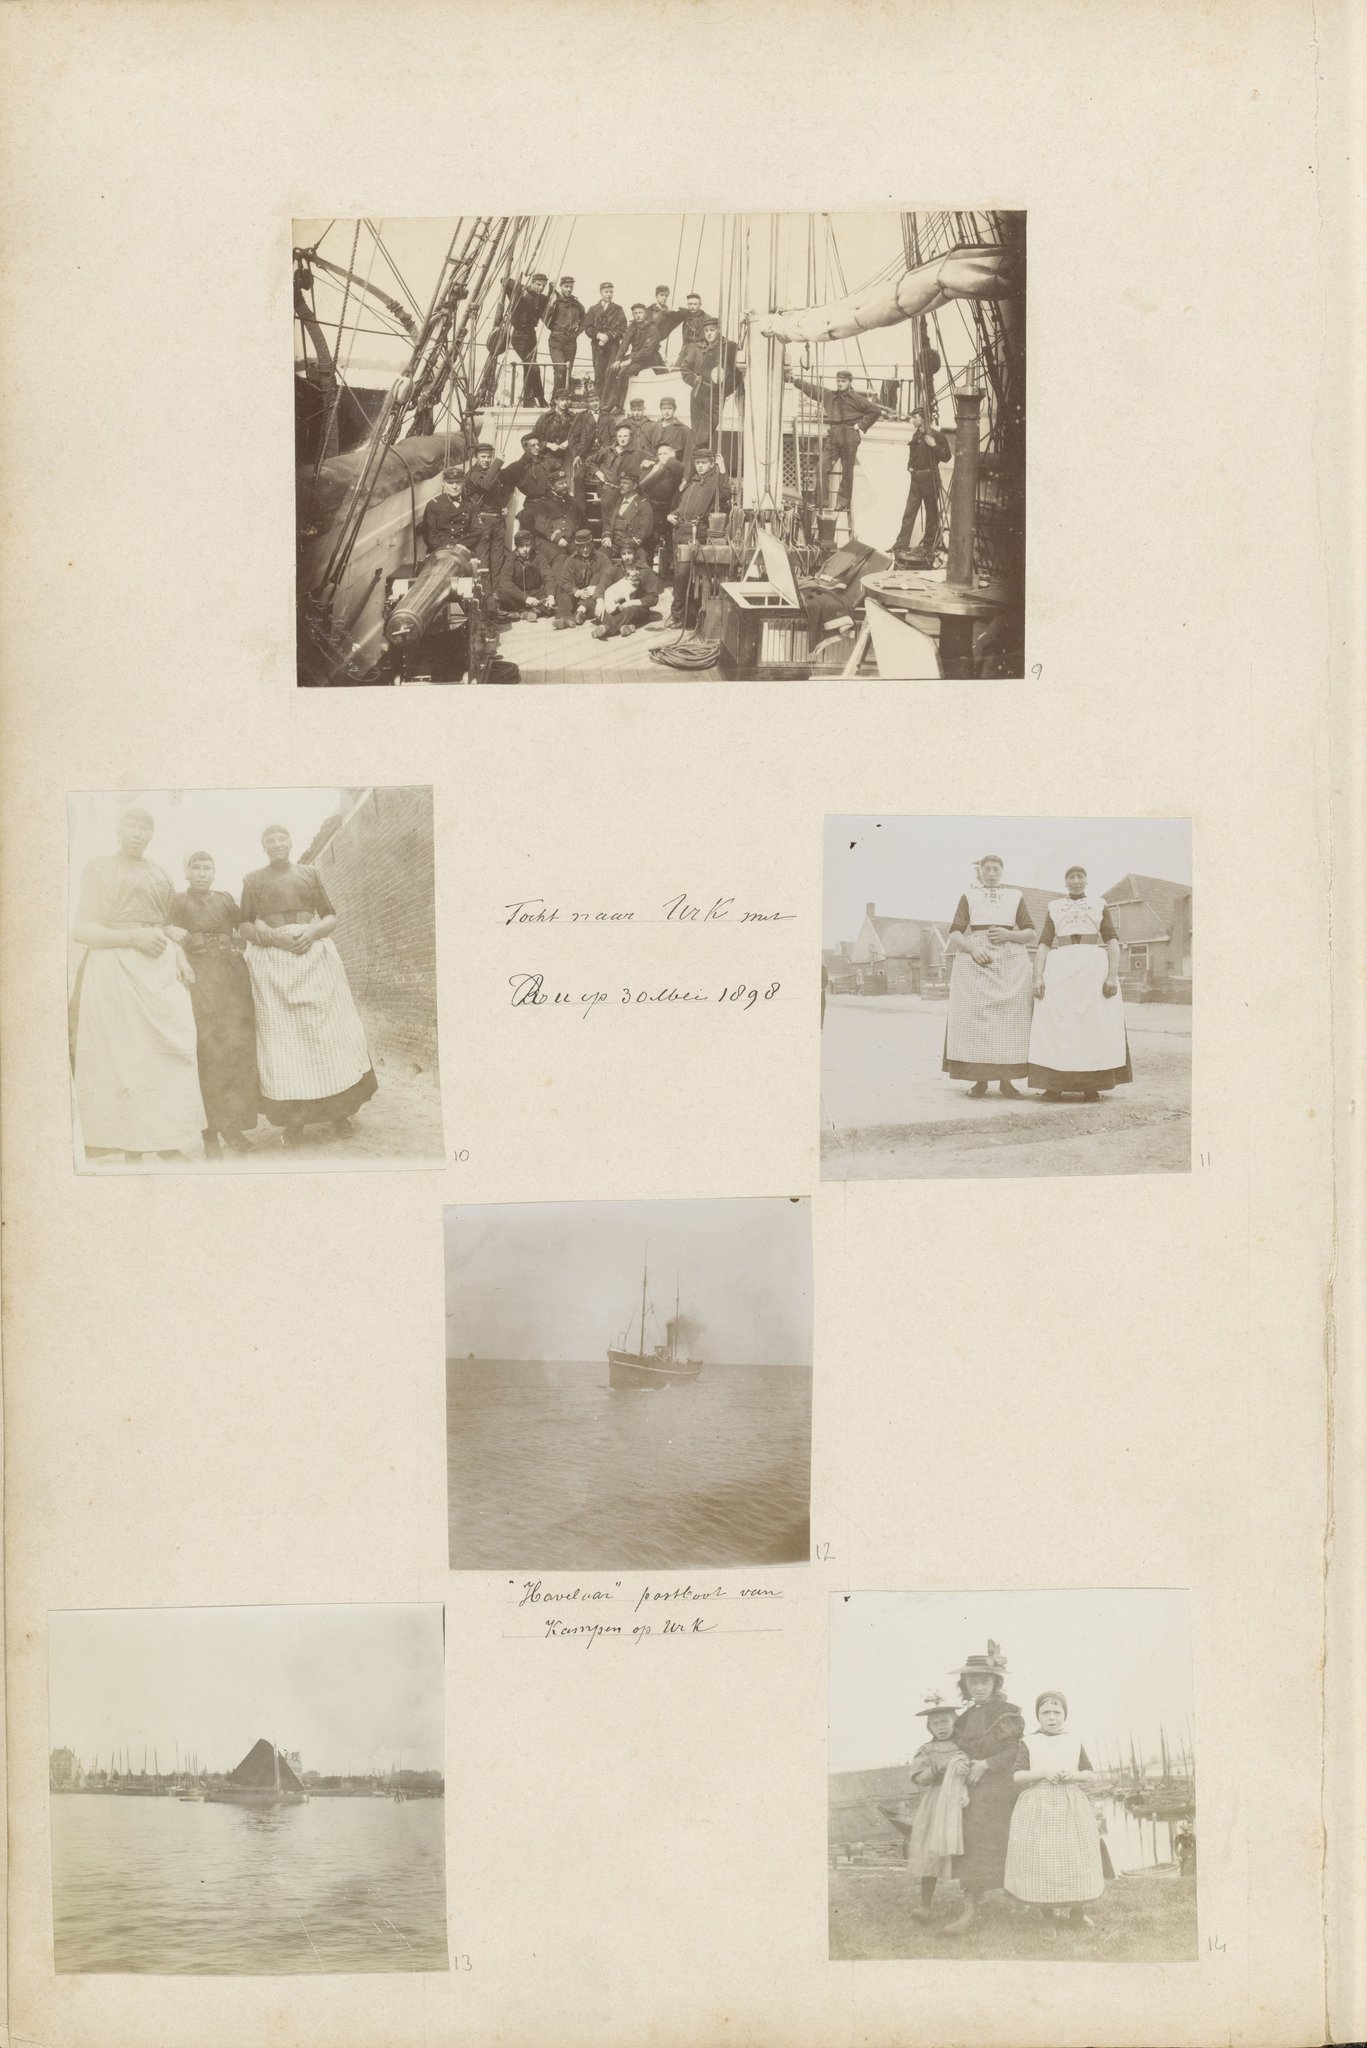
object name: album leaf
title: Gezicht op schepen in een haven, vermoedelijk Urk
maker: Anonymous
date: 1898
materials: paper, photographic support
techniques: matte daylight collodion silver print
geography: urk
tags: harbour (+ view ~ vehicle, ship, etc.)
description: Foto genomen tijdens een tocht naar Urk met Rudloph Maximiliaan Crommelin (1887-1959). Onderdeel van Fotoalbum van Robert Daniel Crommelin (1841-1907).